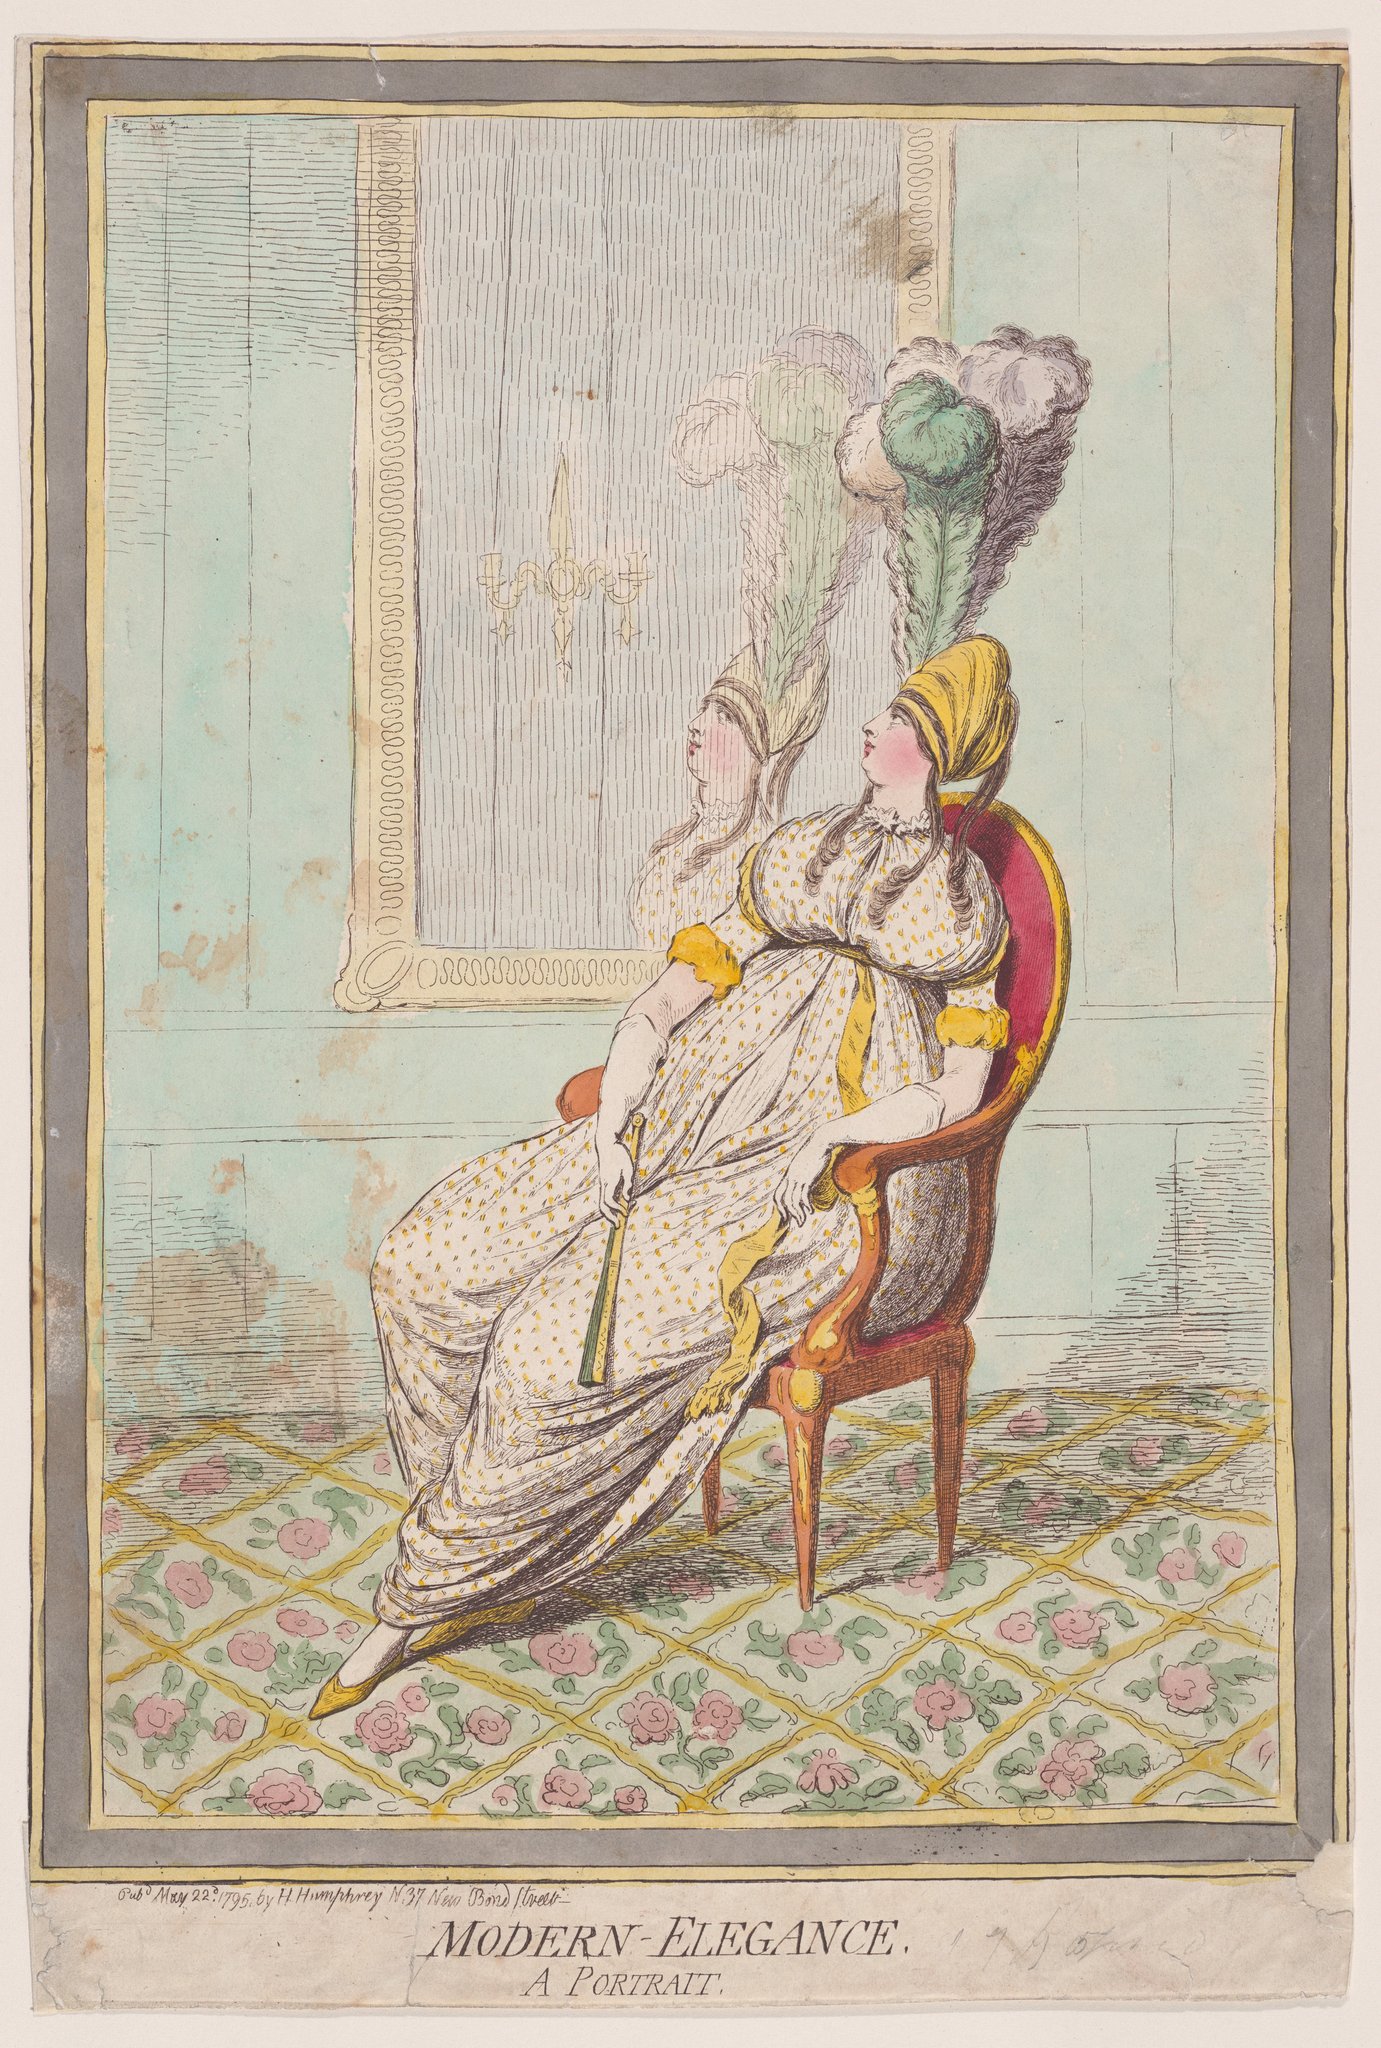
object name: print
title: Modern Elegance, a Portrait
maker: james gillray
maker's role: artist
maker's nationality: british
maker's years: 1756-1815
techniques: etching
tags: women,caricature